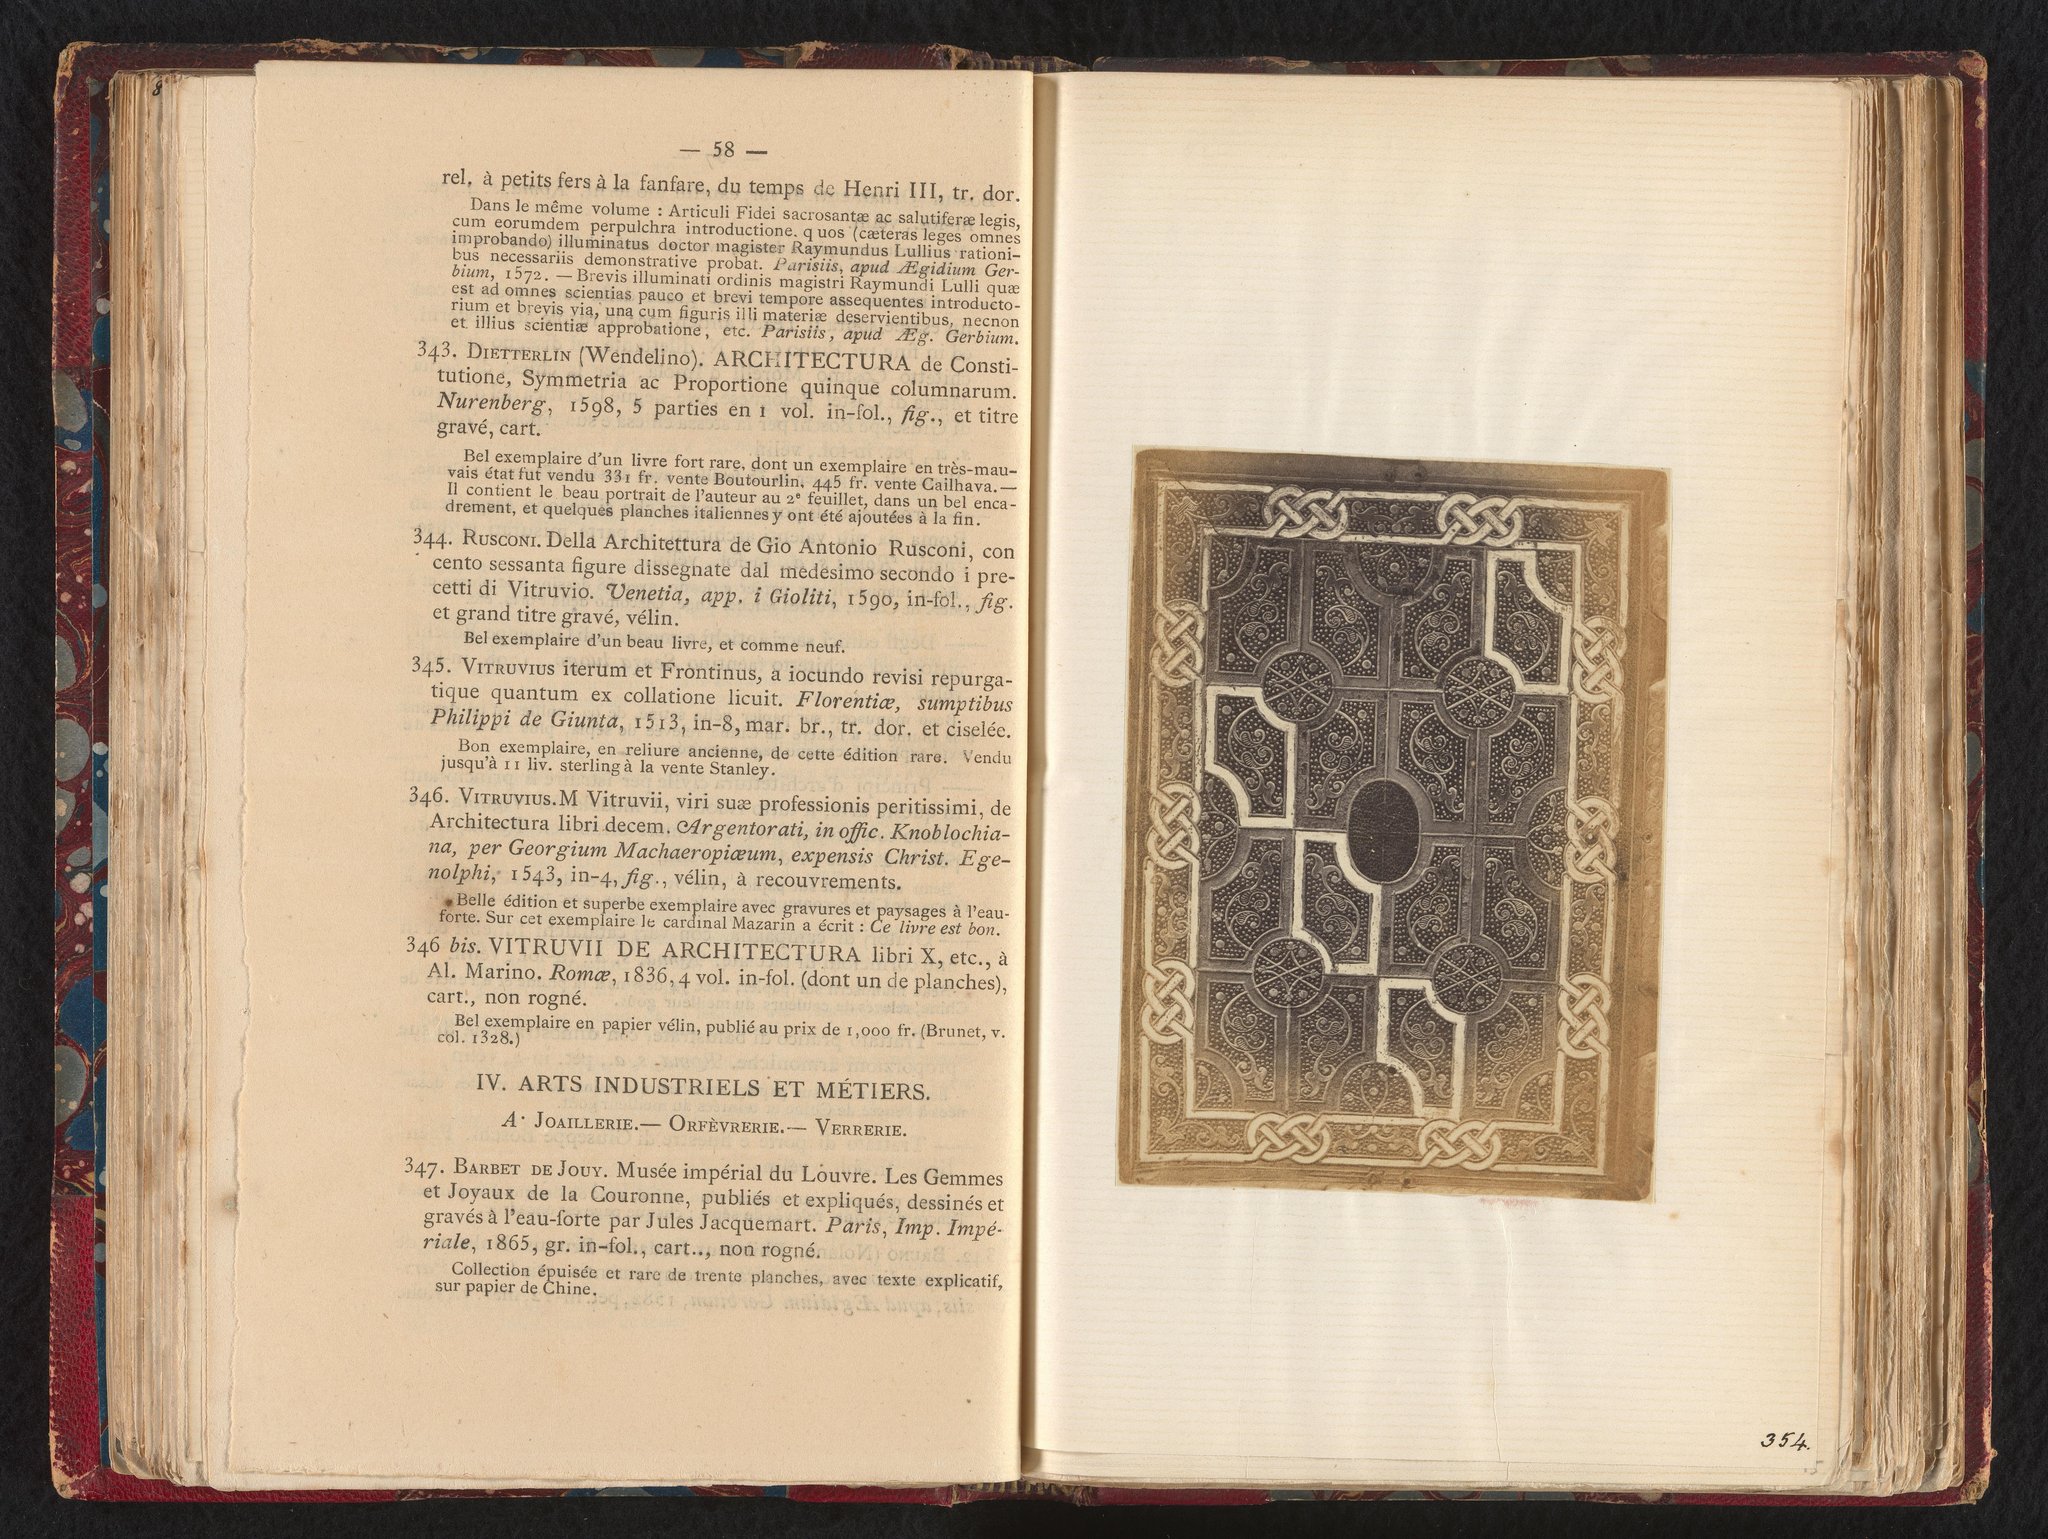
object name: reproduction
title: Fotoreproductie van boekomslag van Libro di Segreti et di Famiglia van Lorenzo de Medici uit de zestiende eeuw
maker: Anonymous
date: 1863-1868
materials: paper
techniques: albumen print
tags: book-cover, binding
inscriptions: number: ‘354’